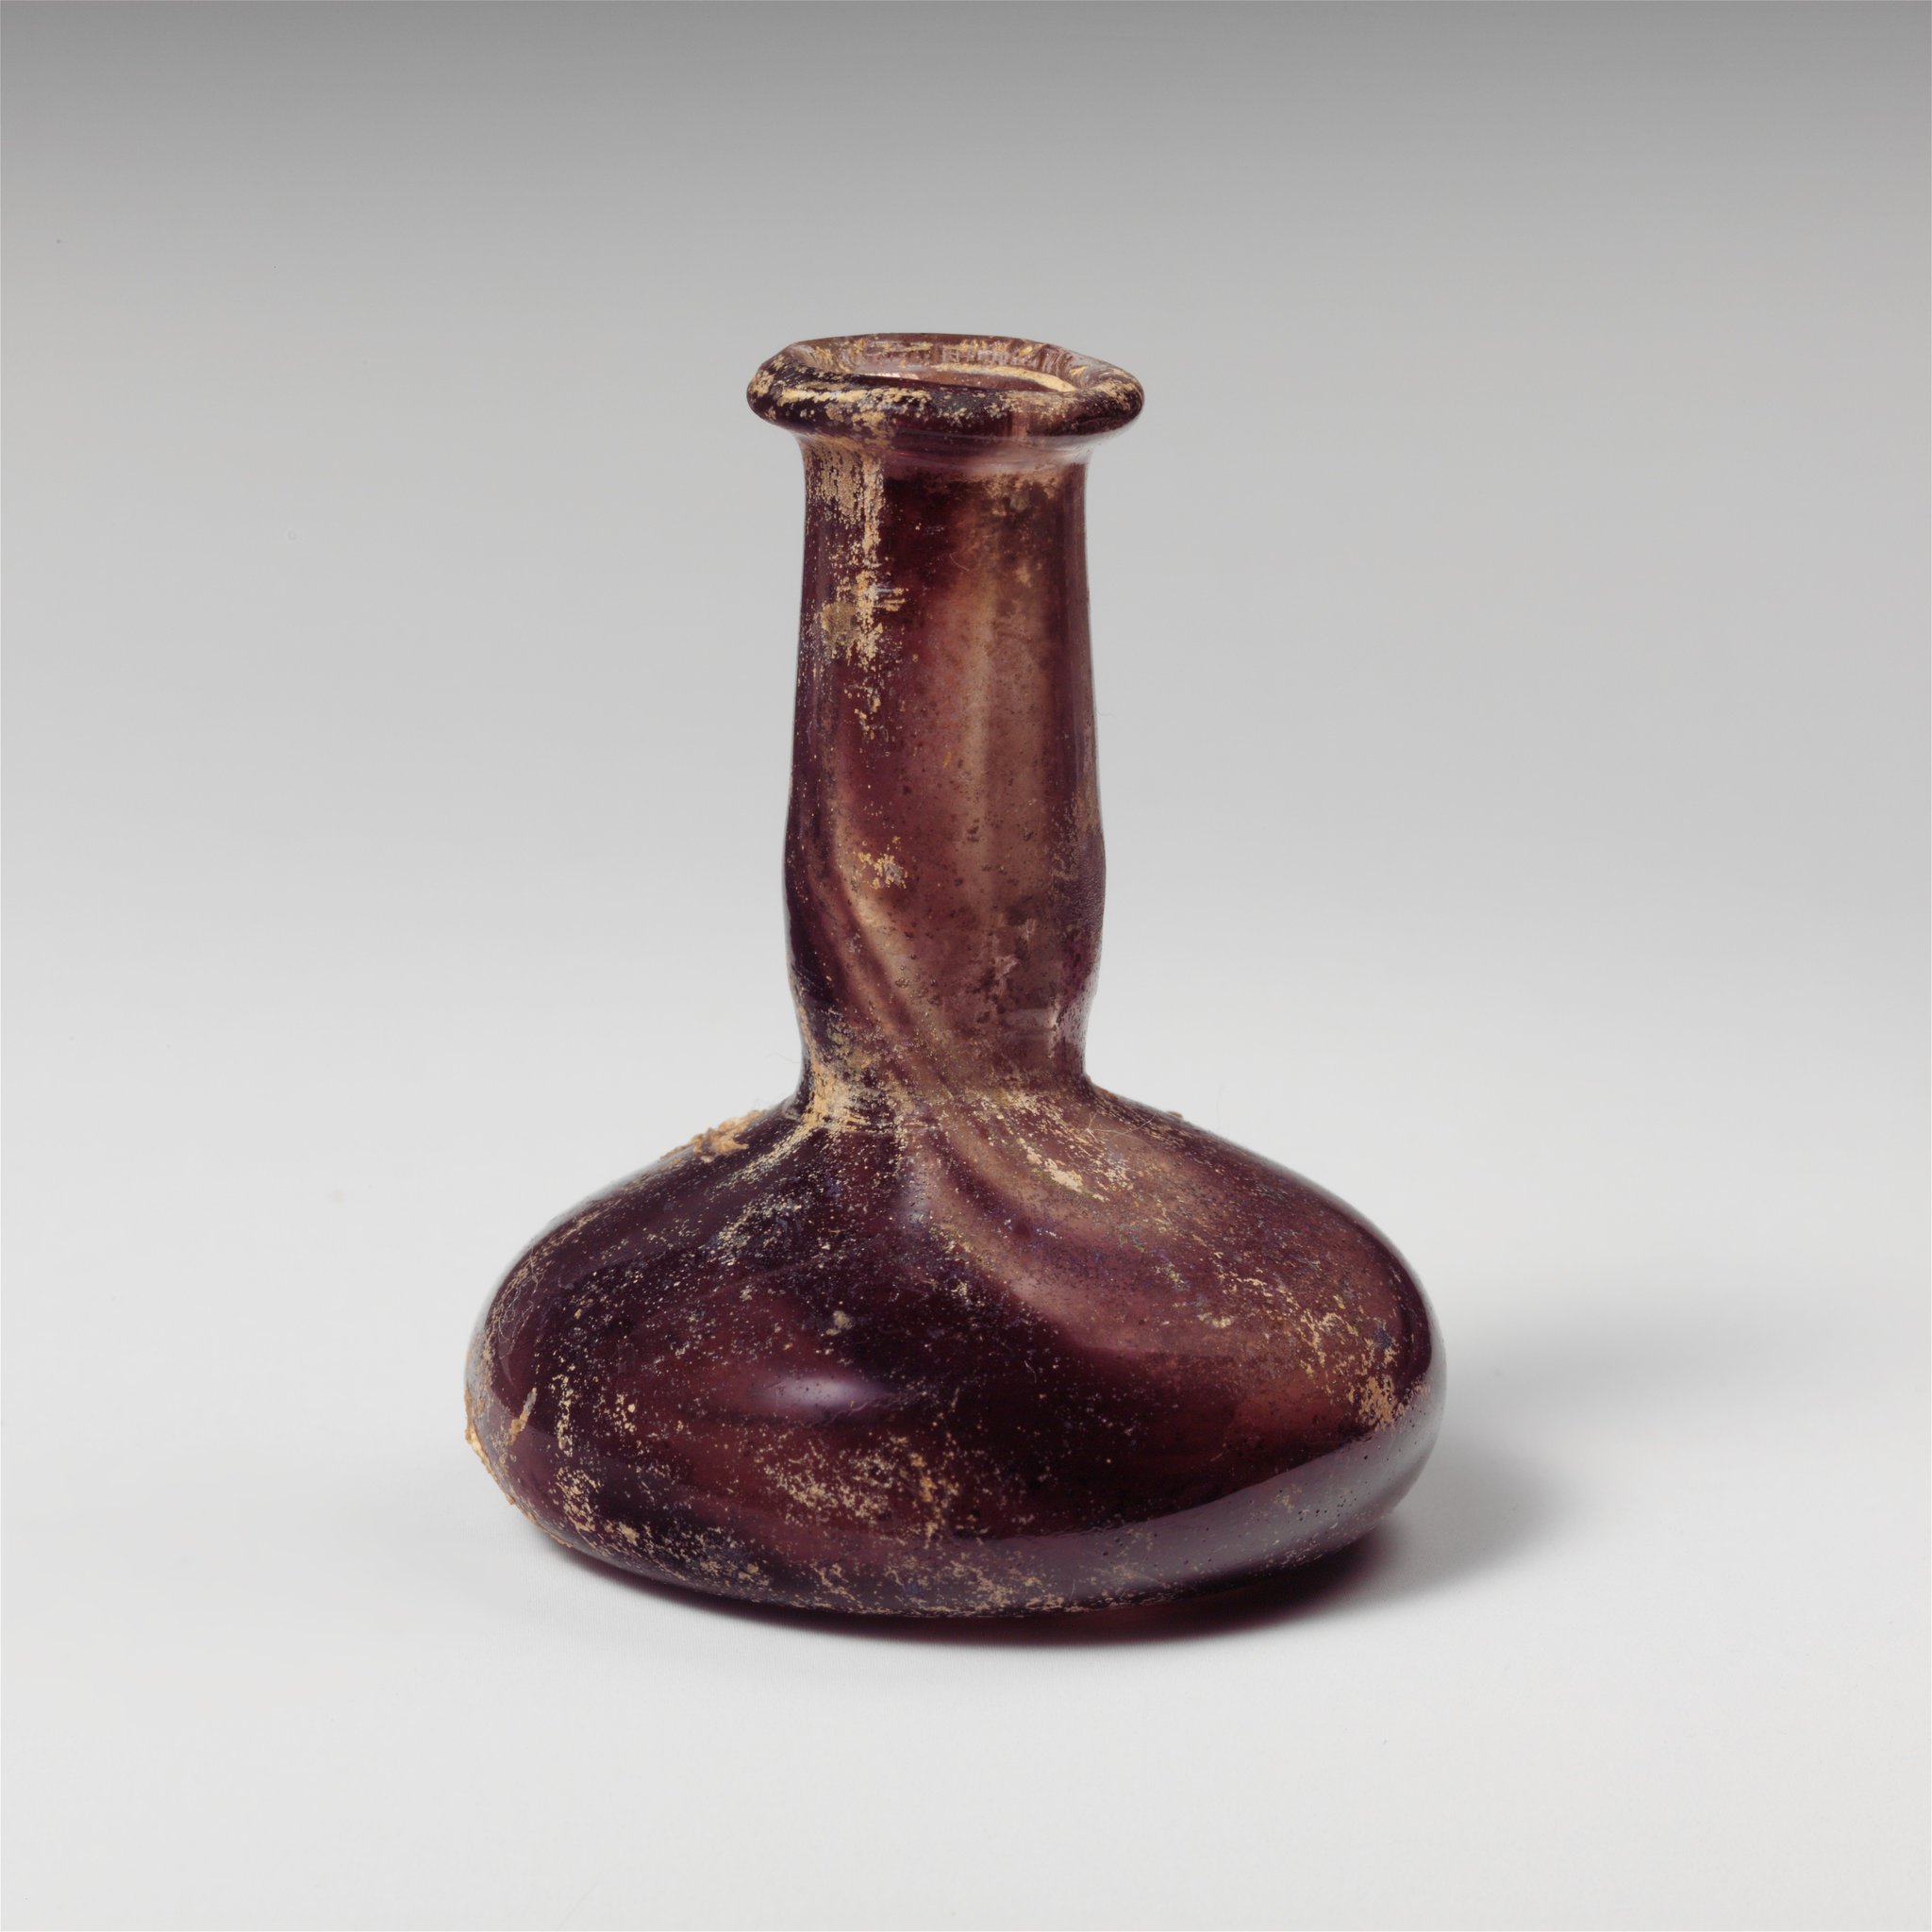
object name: perfume bottle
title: Glass perfume bottle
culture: roman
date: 1-200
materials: glass